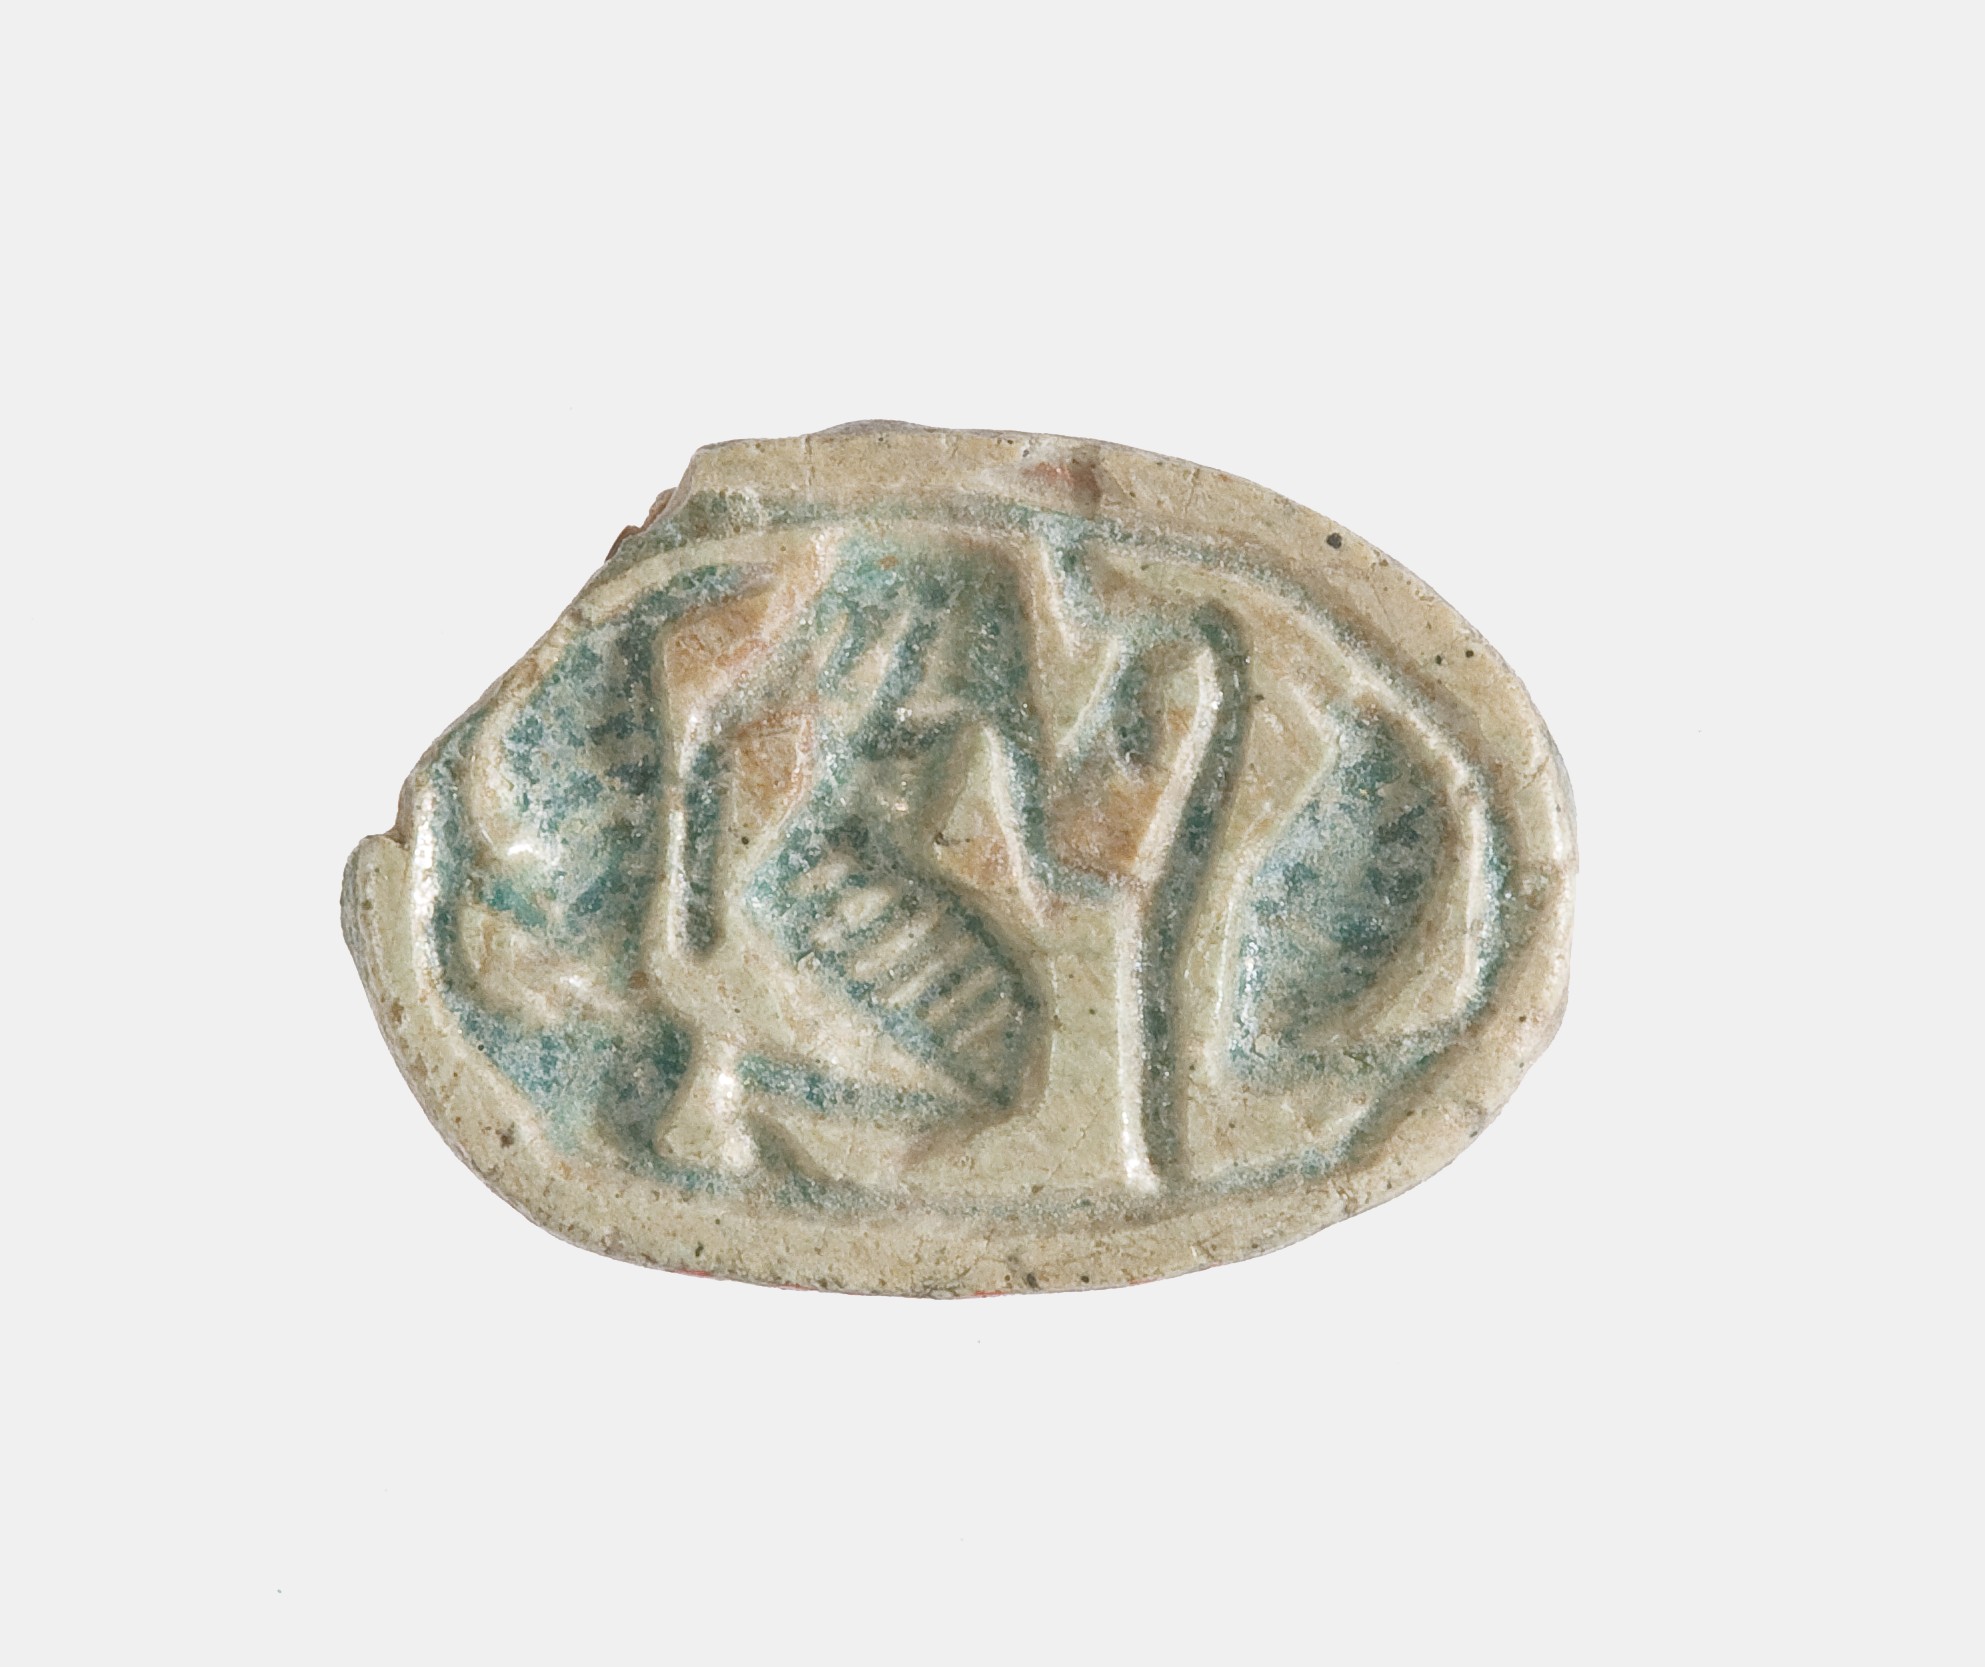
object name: scarab, falcon headed figure, horus, uraei, lotus stalk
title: Scarab with the Representation of a Falcon-headed Figure Between Uraei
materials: stone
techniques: glazing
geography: egypt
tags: hieroglyphs,scarabs